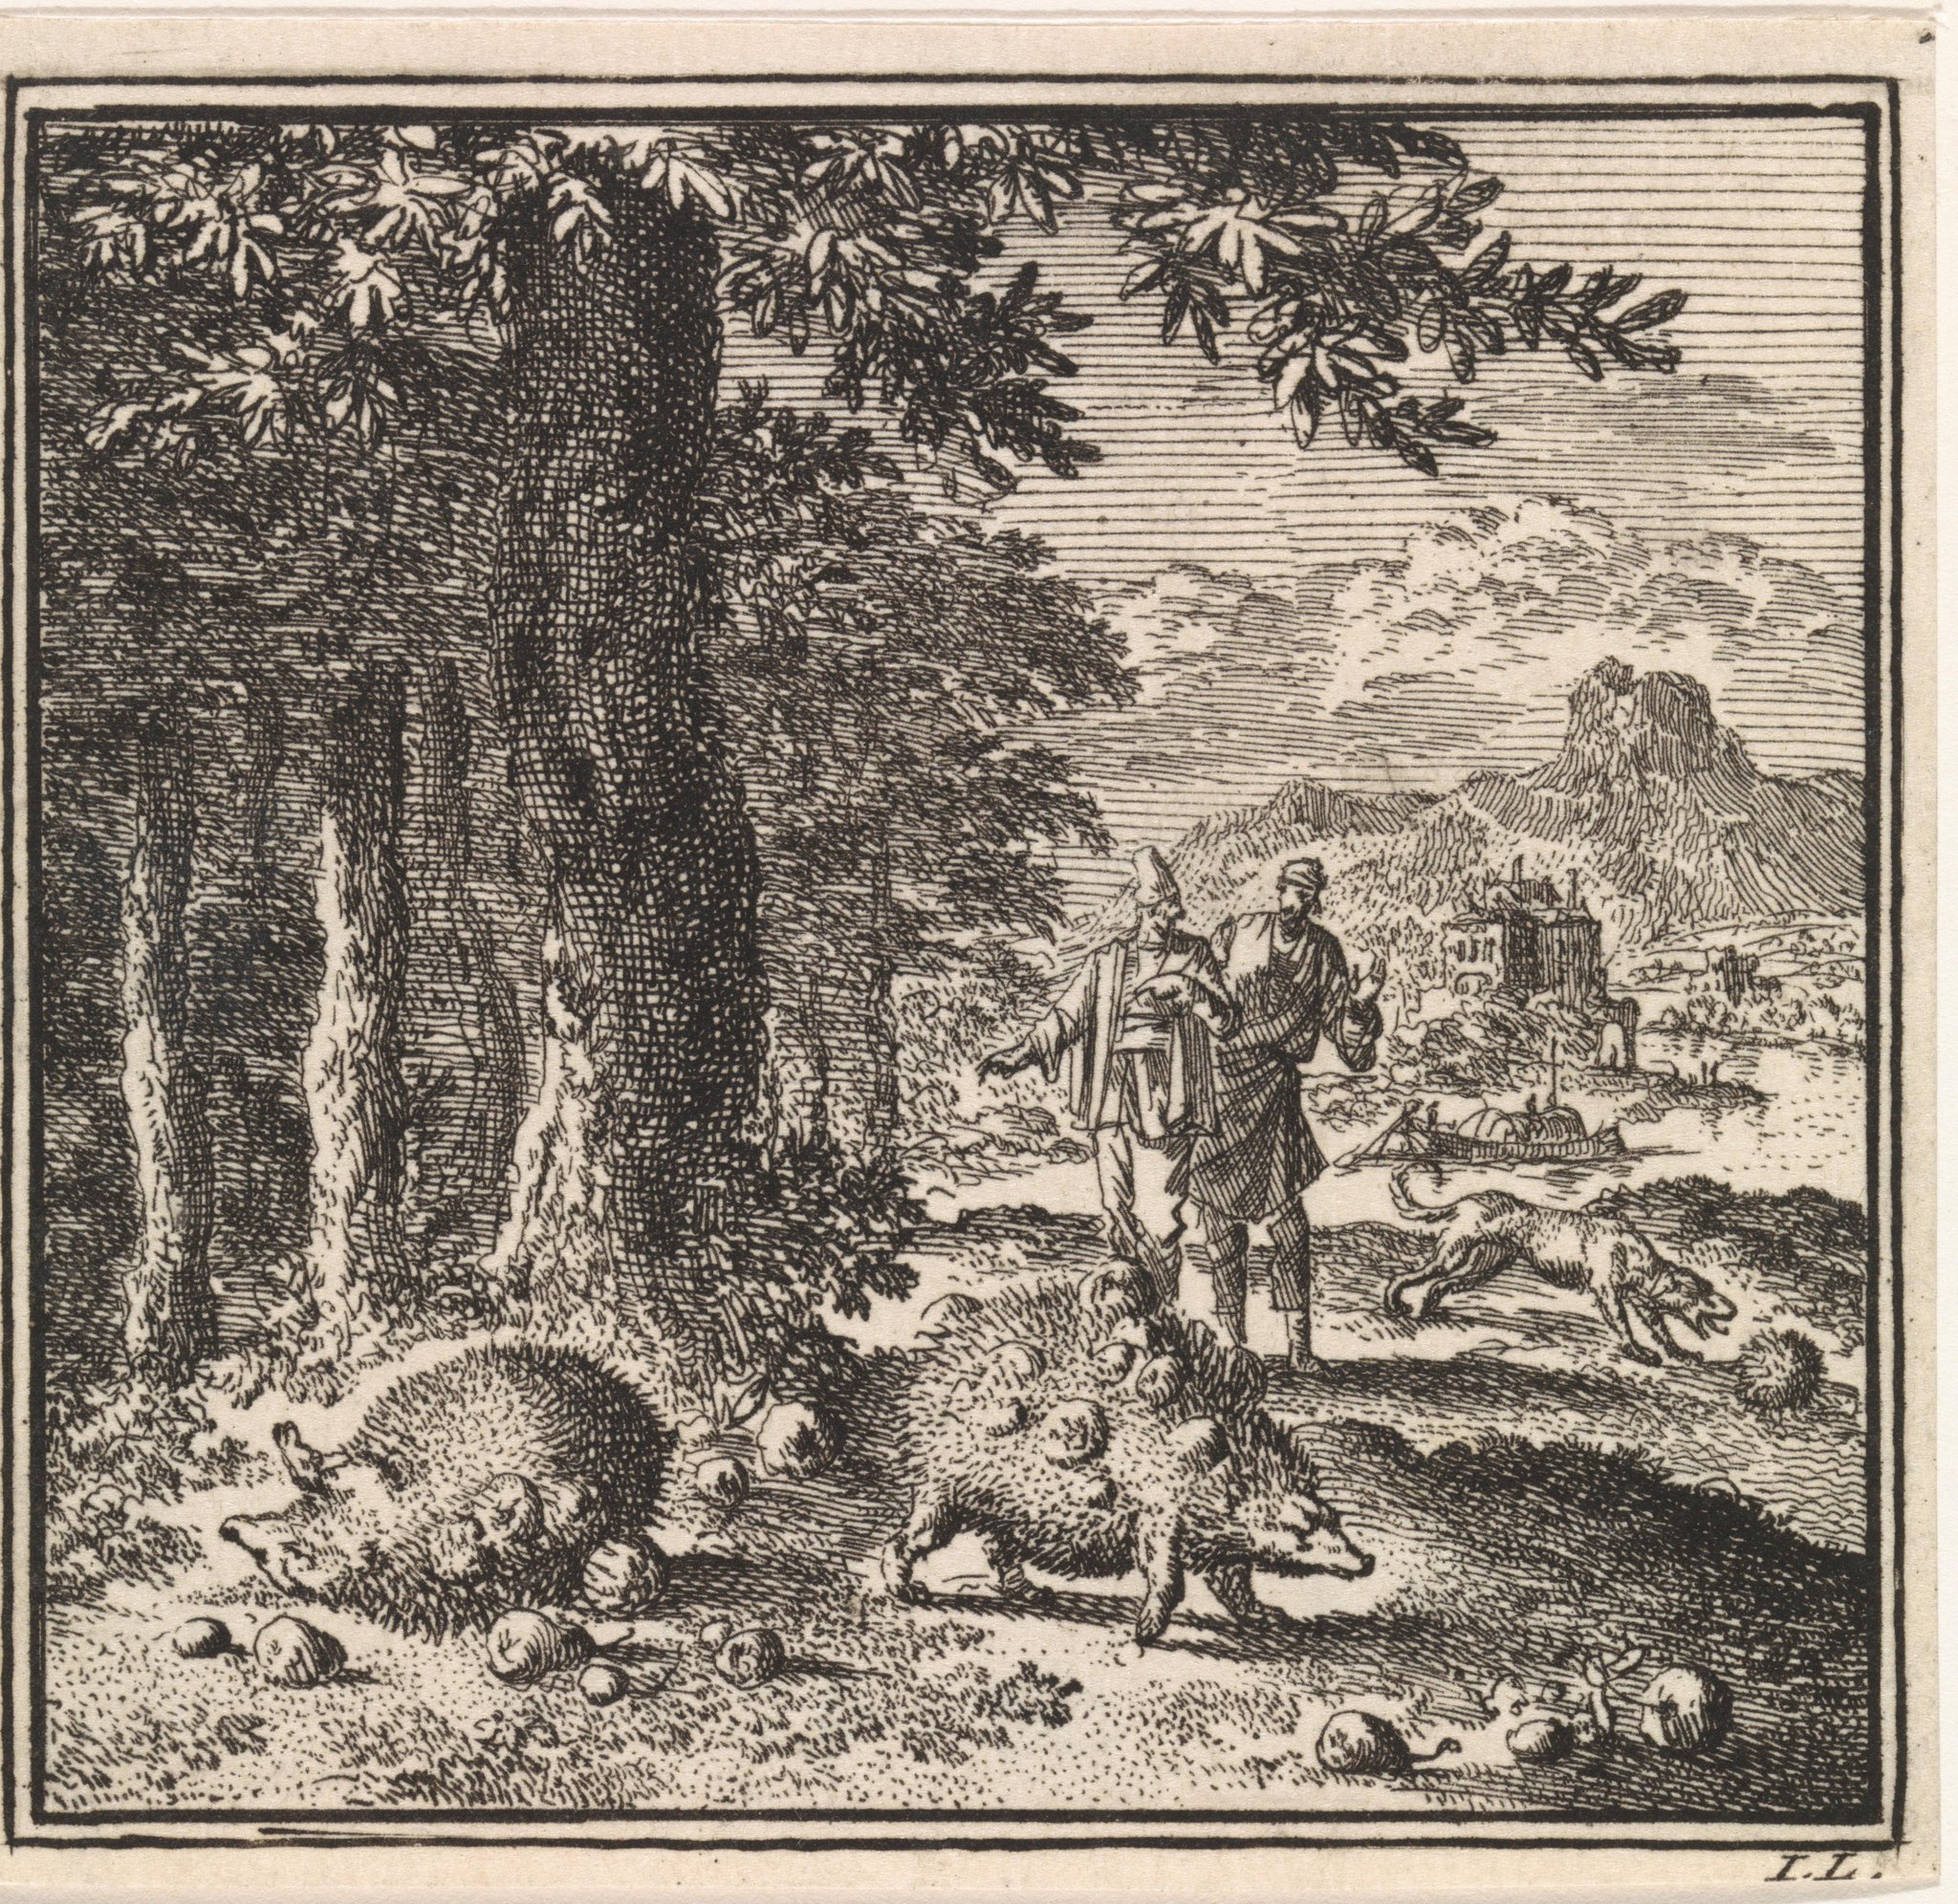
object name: print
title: Drie egels aan de rand van een bos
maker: jan luyken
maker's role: draughtsman, print maker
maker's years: 1649-1712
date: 1711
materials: paper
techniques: etching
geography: amsterdam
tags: forest, wood, other mammals: hedgehog, fruits, dog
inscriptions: collector's mark: Lugt 2228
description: Illustratie voor: Luyken, Jan. De Bykorf des Gemoeds. Amsterdam: Pieter Arentsz. II (wed.) en Cornelis van der Sys, 1711, p. 310.